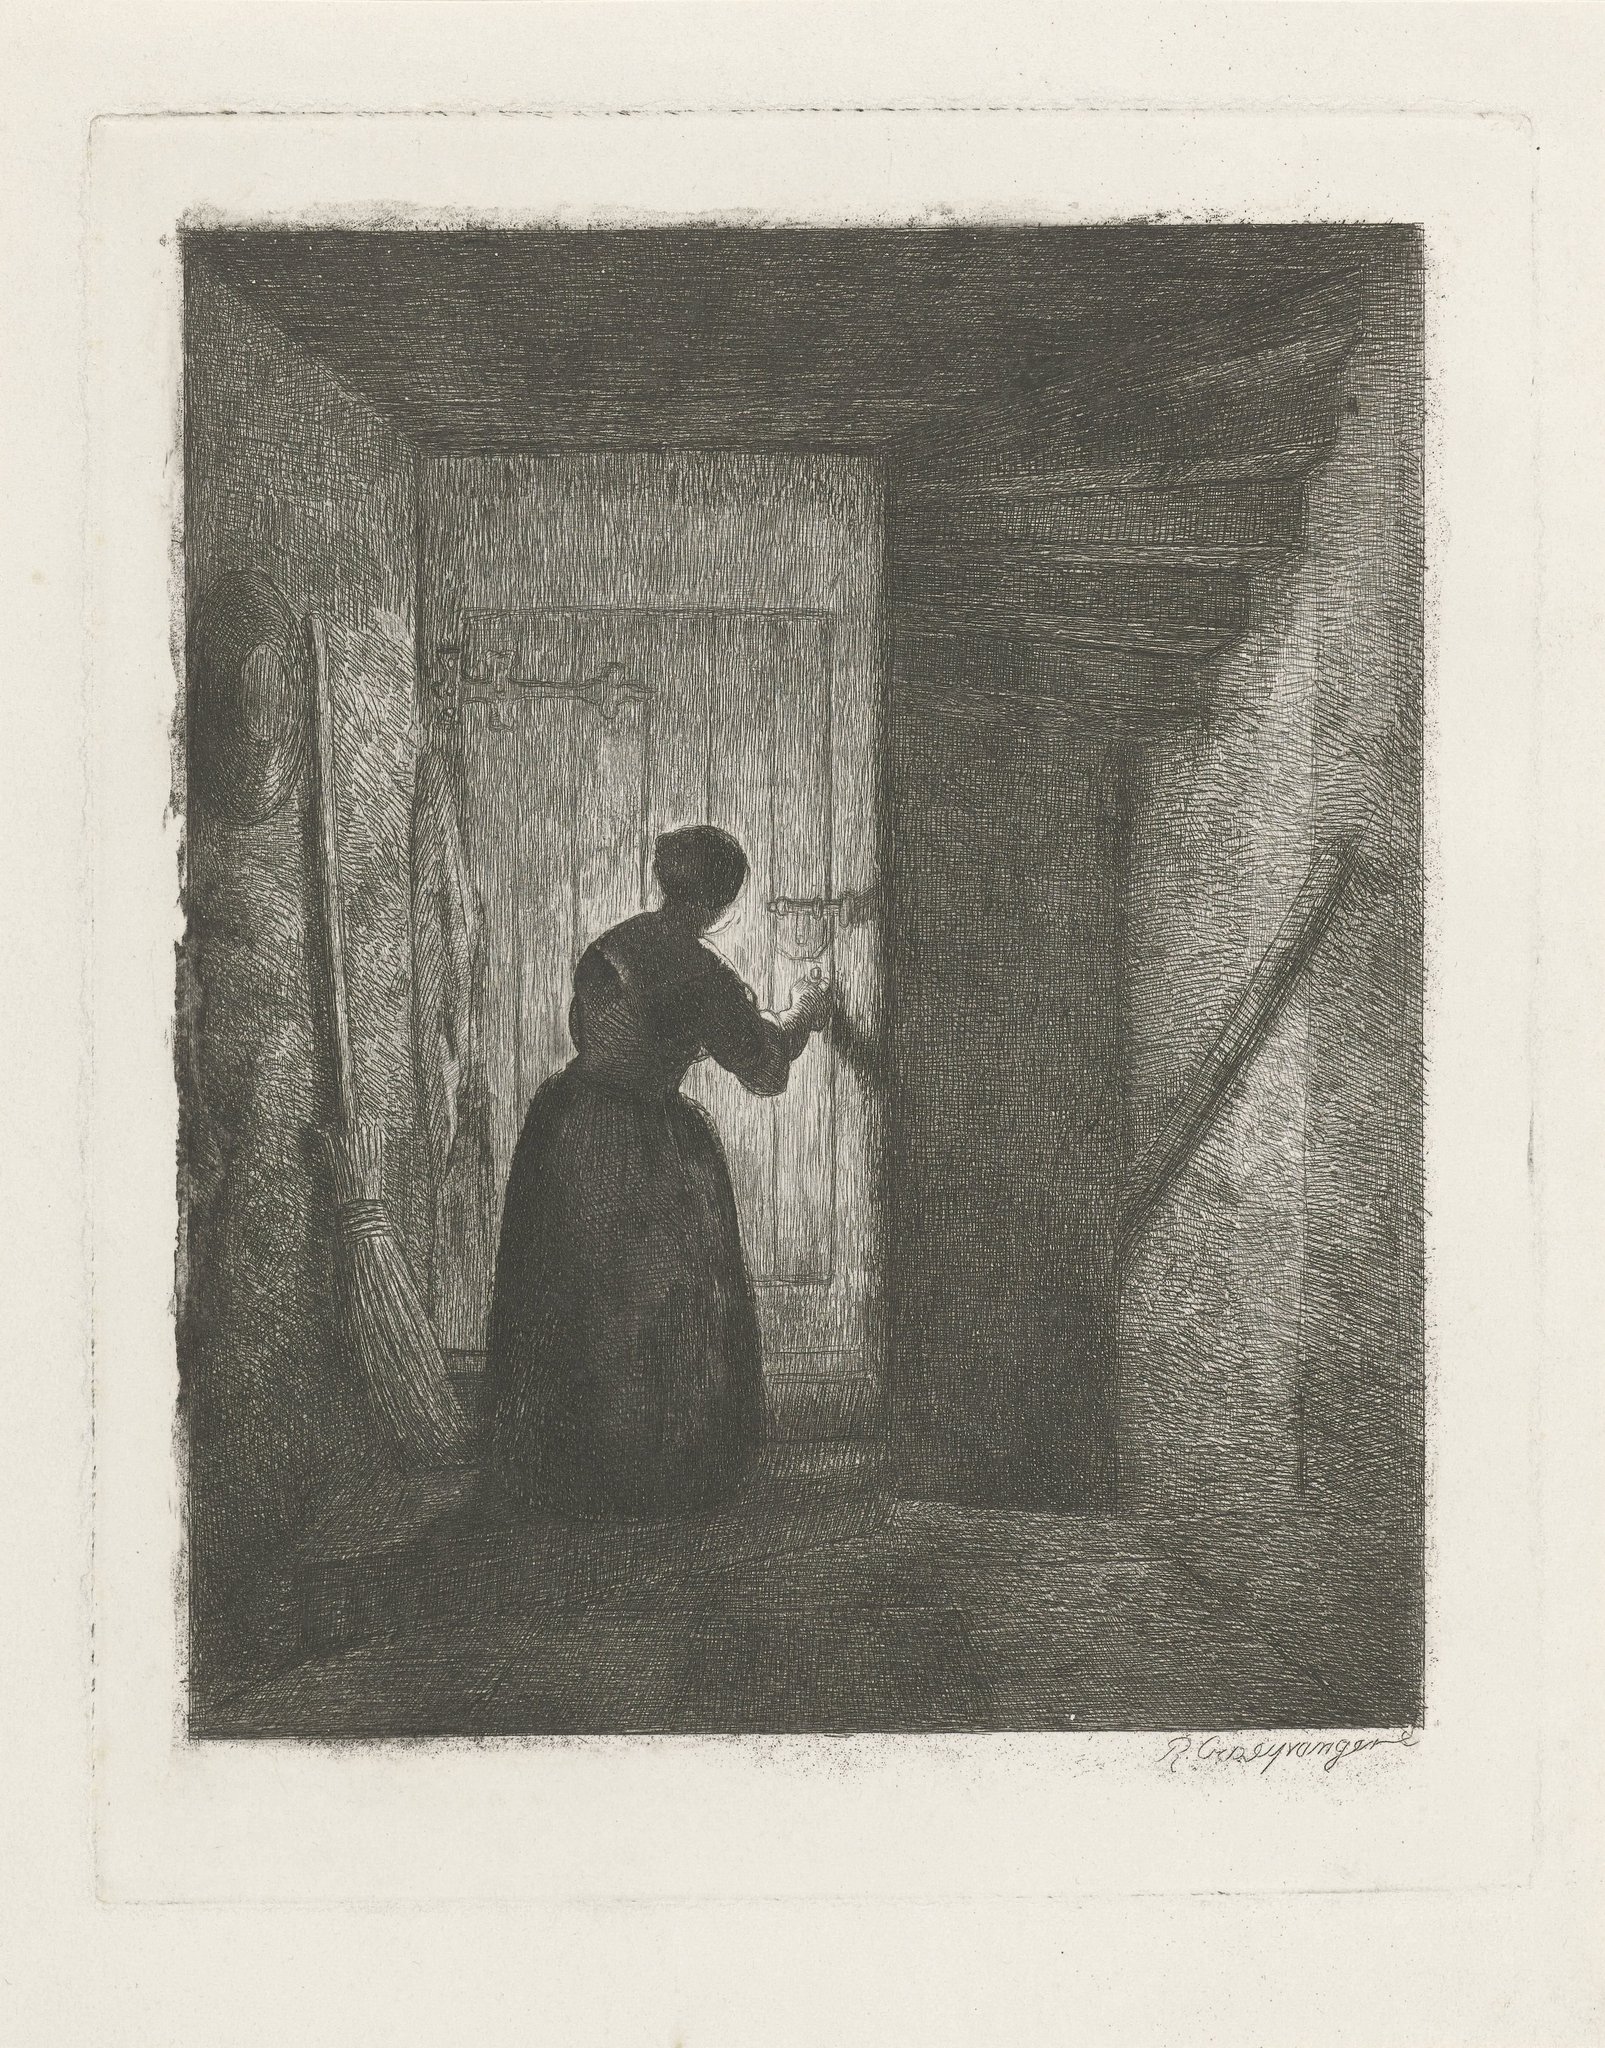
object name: print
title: Vrouw voor een deur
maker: reinier craeyvanger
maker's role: draughtsman, print maker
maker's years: 1812-1880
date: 1822-1880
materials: paper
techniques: etching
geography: amsterdam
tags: adult woman, opening the door, shrubs: broom, closed door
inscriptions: collector's mark: Lugt 2228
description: Een vrouw staat voor een deur en draait aan de sleutel. Rechts een trap naar beneden. Links staat een veger tegen de muur. Een hoed en een jas hangen aan de muur.